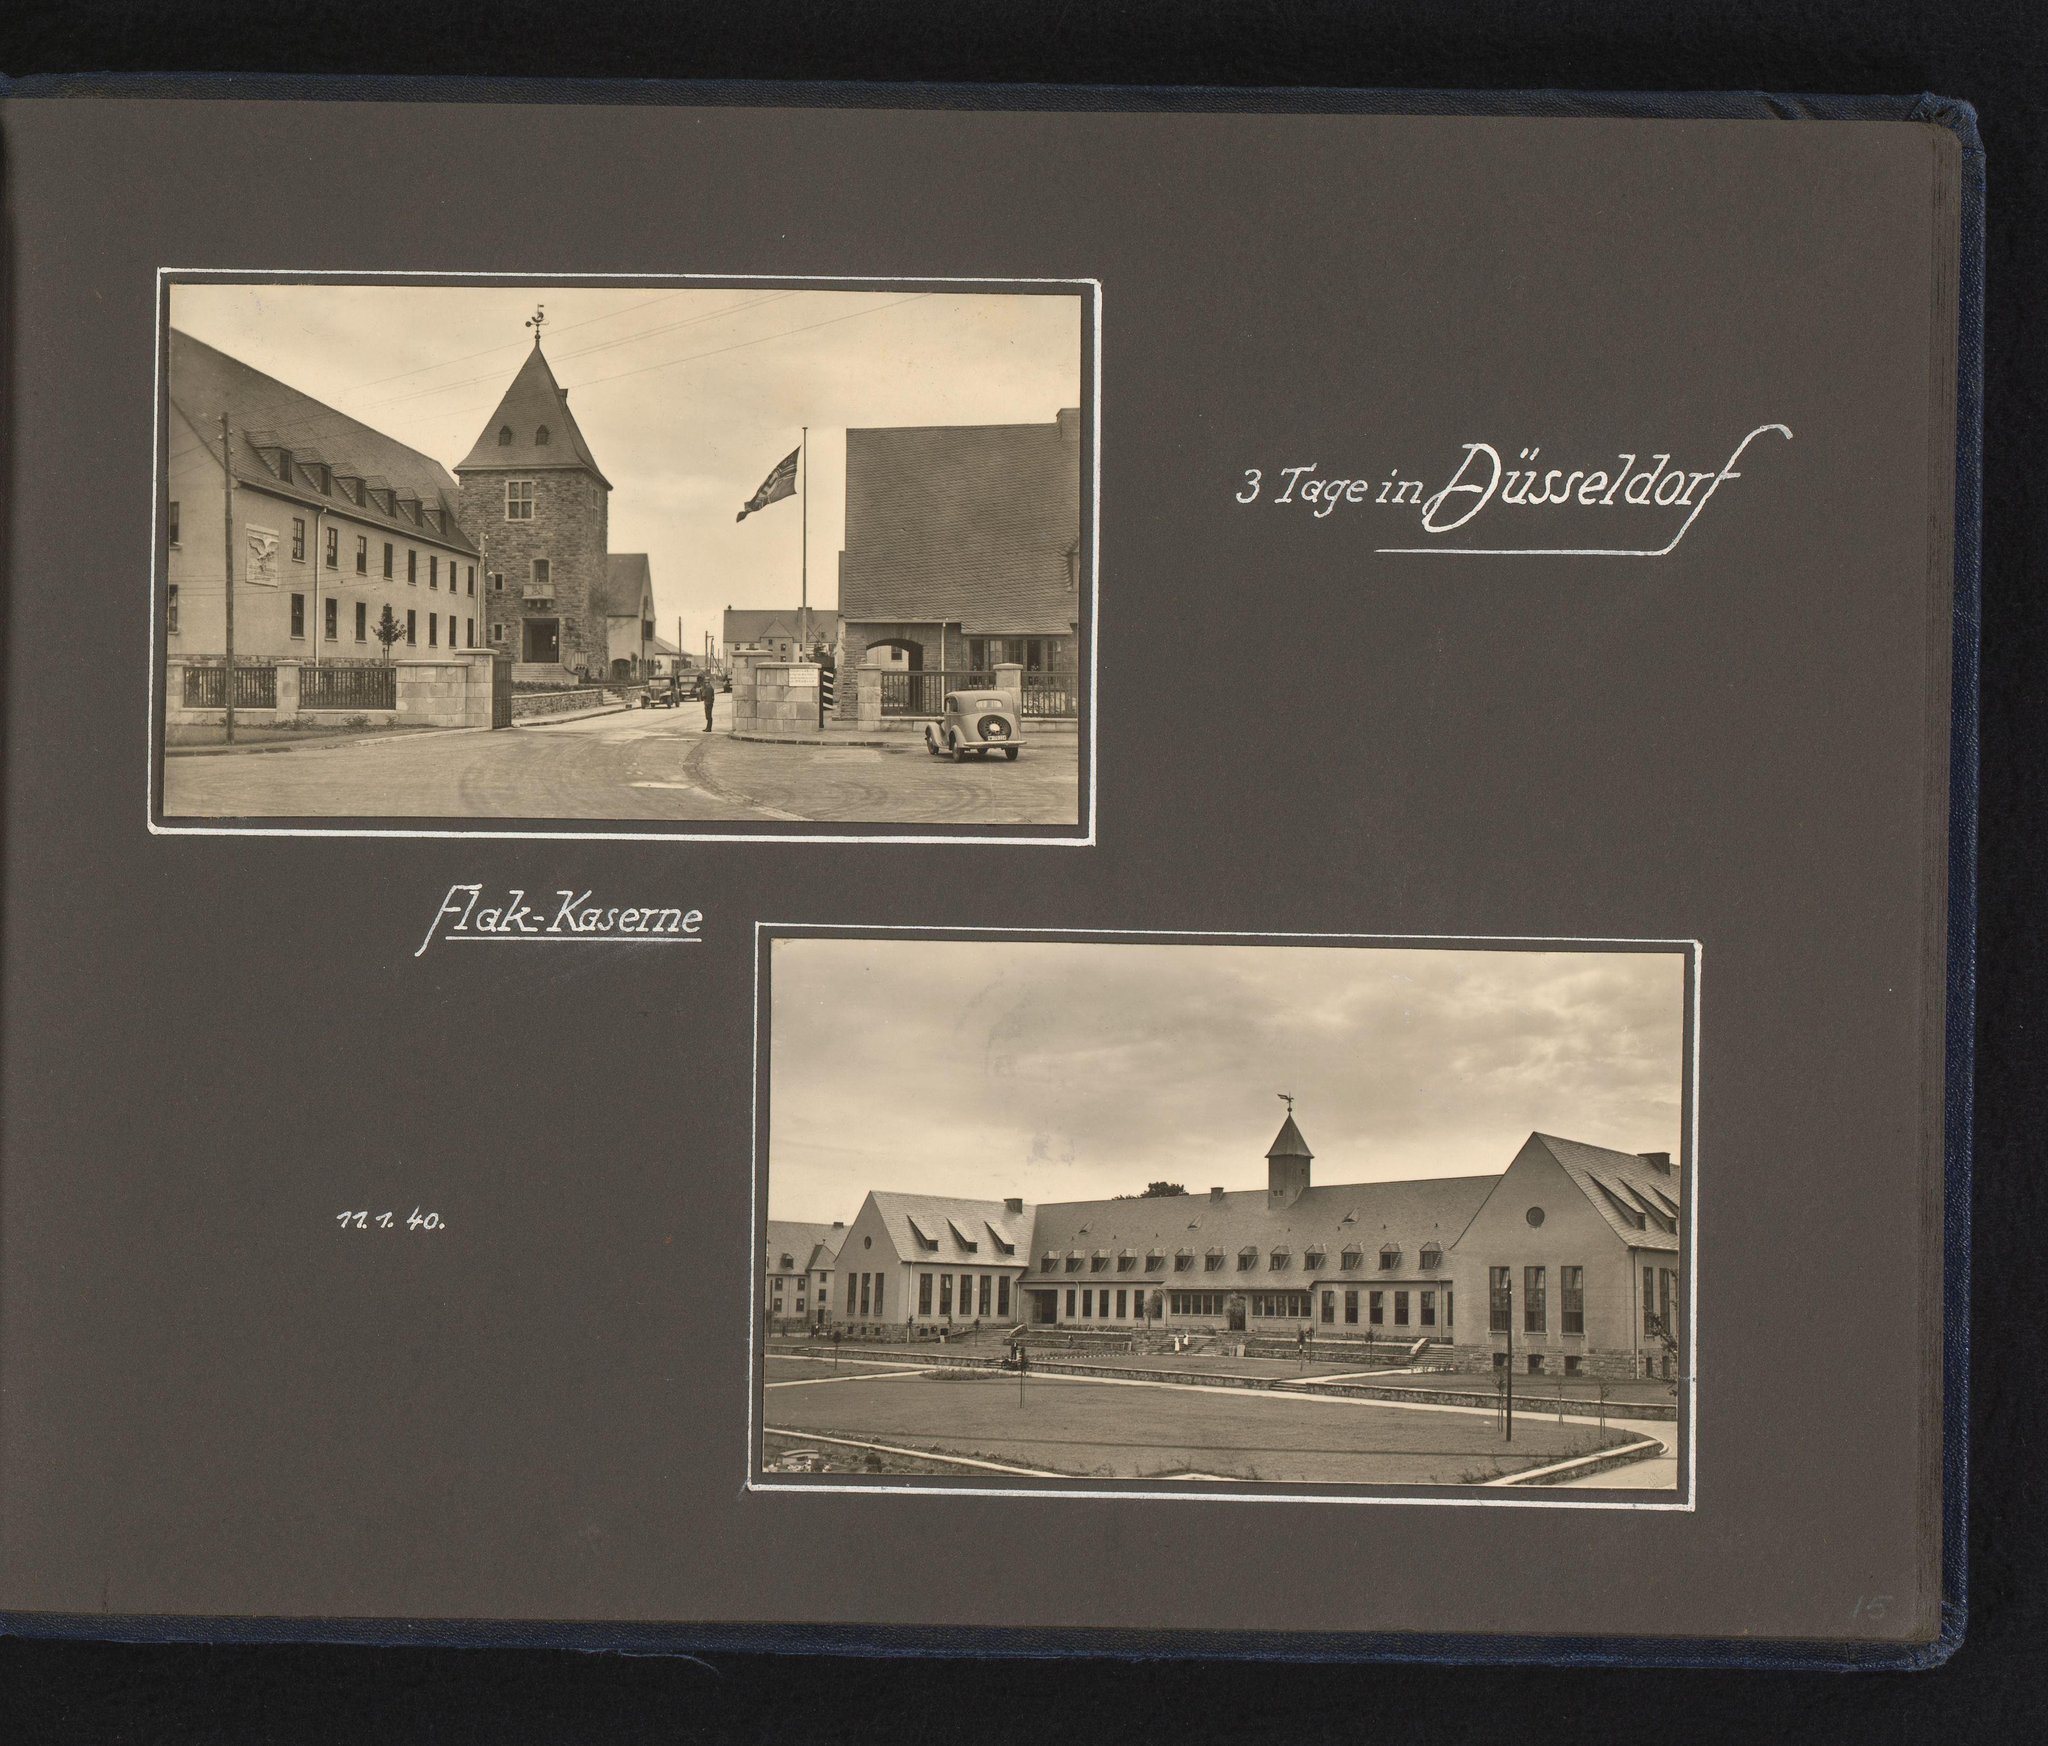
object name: photograph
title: Kazerne te Düsseldorf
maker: Anonymous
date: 1940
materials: paper, photographic support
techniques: gelatin silver print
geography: dusseldorf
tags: barracks, germany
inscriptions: inscription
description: Albumblad met twee foto's van de 'Flak-Kaserne' te Düsseldorf, januari 1940. Onderdeel van een Duits militair album Tweede Wereldoorlog 1939-1940.